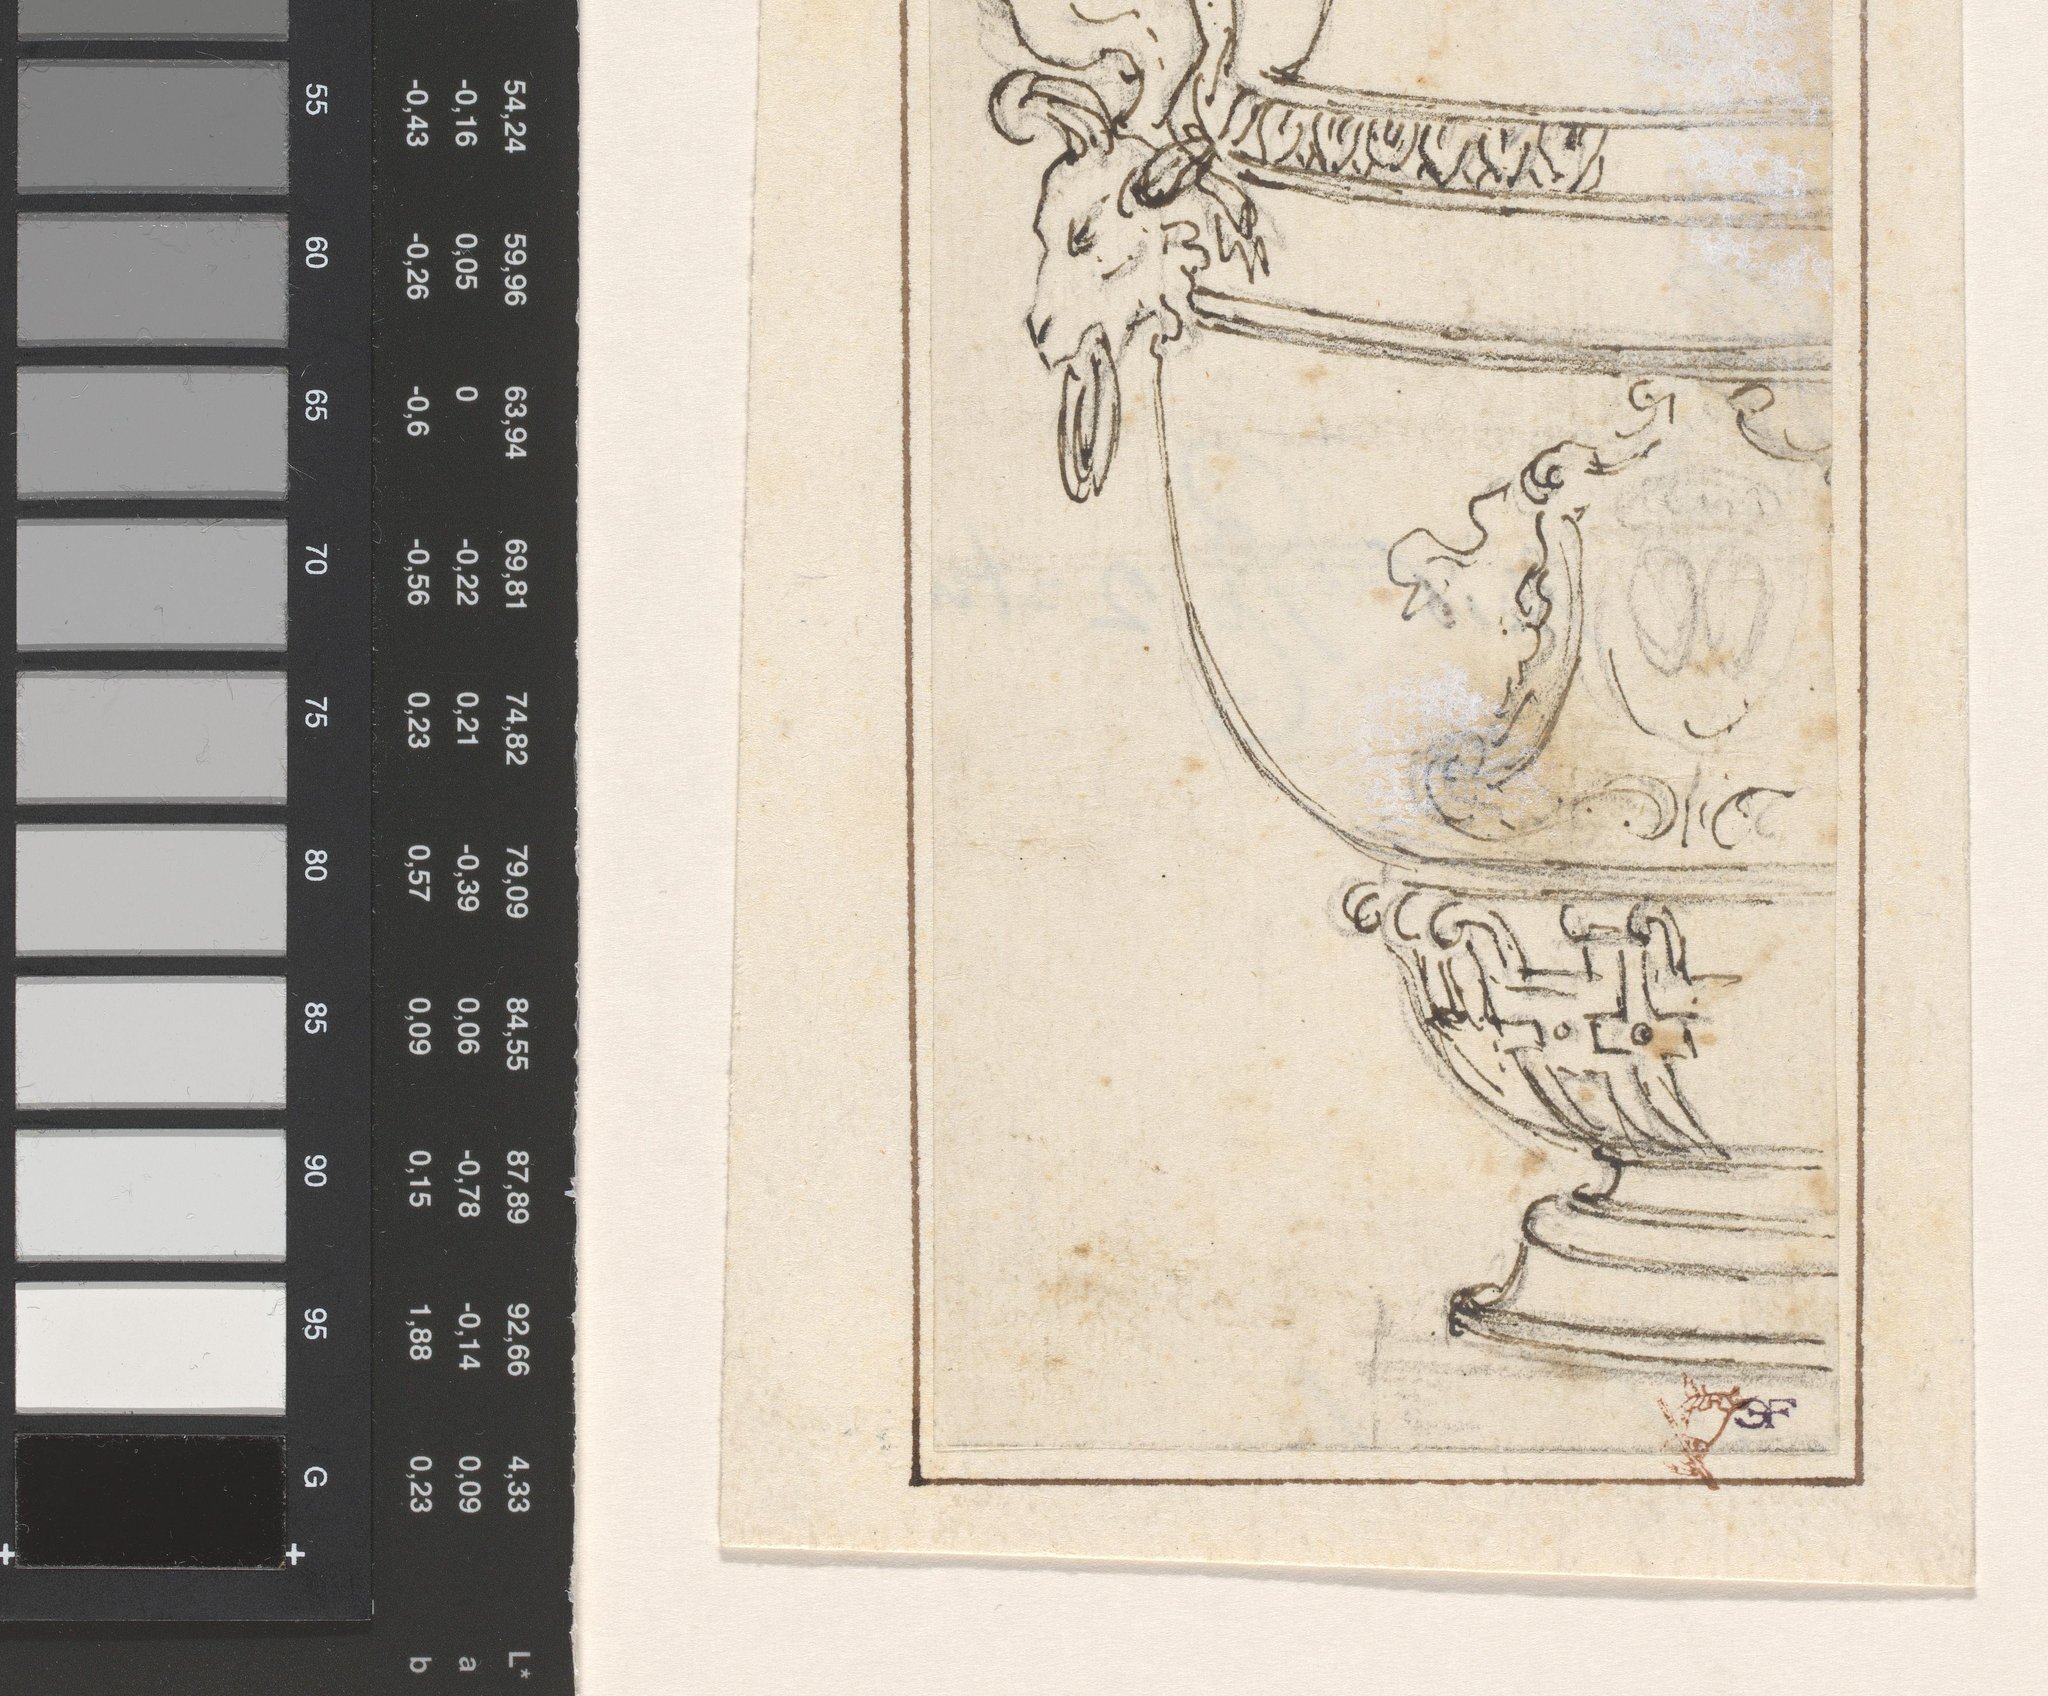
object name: drawing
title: Ontwerp voor de linkerhelft van een vaas met een oor in de vorm van een op een geitenkop zittende naakte vrouw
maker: Anonymous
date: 1760-1780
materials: chalk, ink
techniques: drawing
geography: italy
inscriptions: collector's mark: ‘Lodewijk Houthakker (1926-2008)’ Lugt 3893, collector's mark: ‘Edmond Fatio (1871-1959)’ Lugt 3472